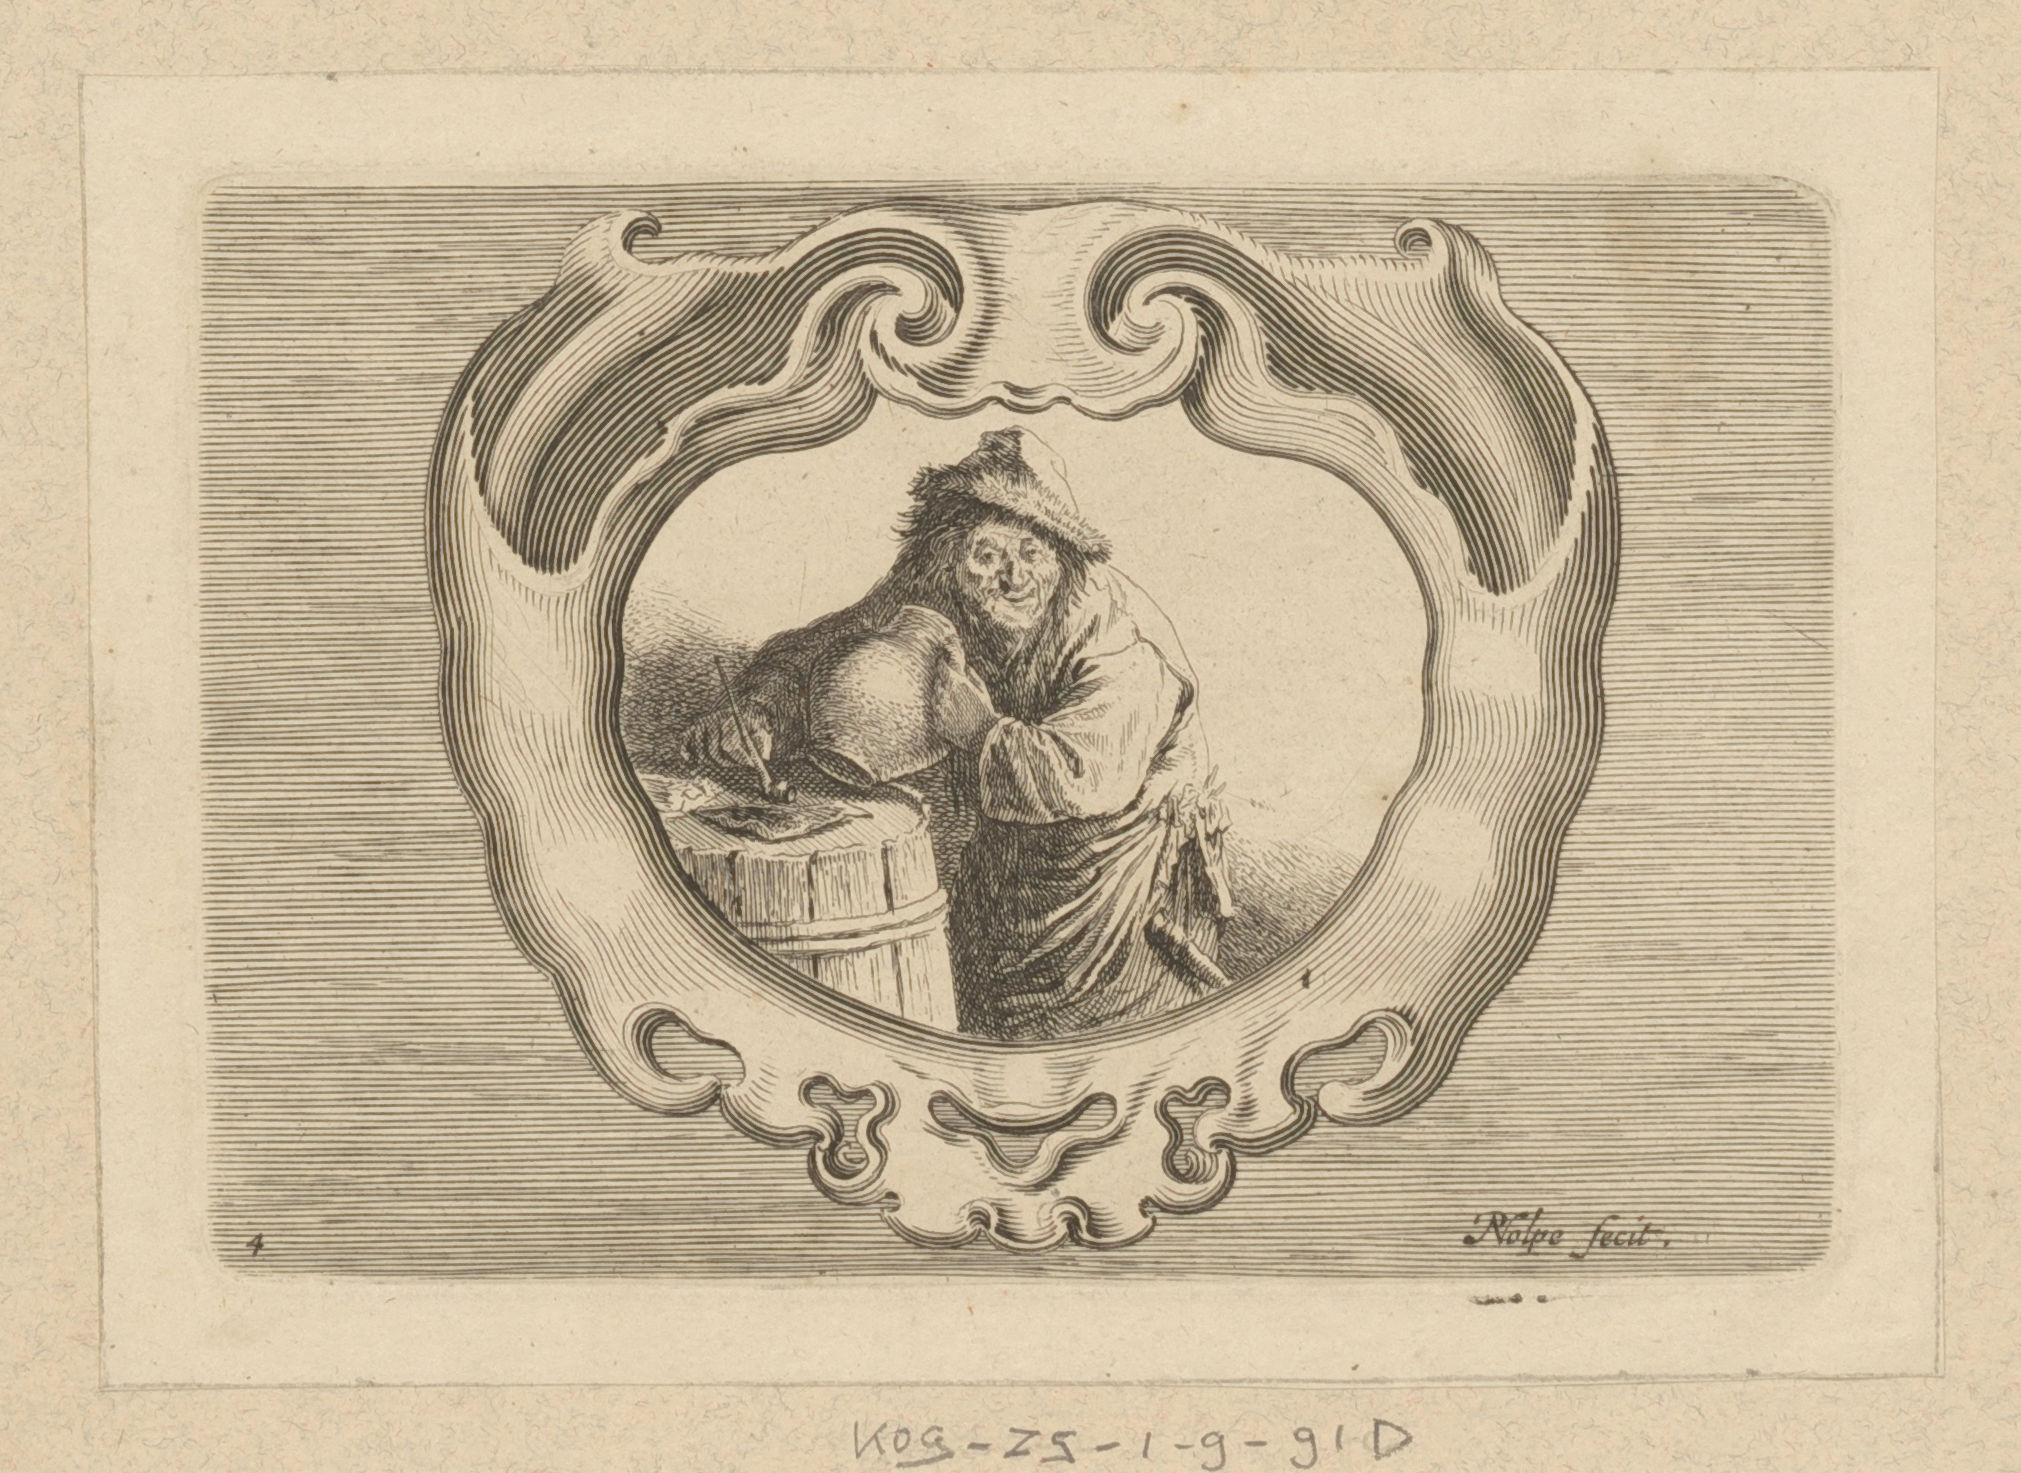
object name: print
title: Scènes uit het boerenleven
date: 1633-1679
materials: paper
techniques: engraving, etching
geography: amsterdam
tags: wooden container: barrel, cask, bucket, jar, jug (used as drinking-vessel), farmers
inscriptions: collector's mark: Lugt 1641, stamp:, collector's mark: Lugt 963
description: Een oude boer staat bij een houten ton met een kruik in de ene en een pijp in de andere hand. De voorstelling is gevat in een ornamentele kwablijst. Prent maakt deel uit van een serie met scènes uit het boerenleven. Onderwerpsrubrieken binnen de Atlas Zeden en Gewoonten: Handel, nijverheid en verkeer, Boerenleven.